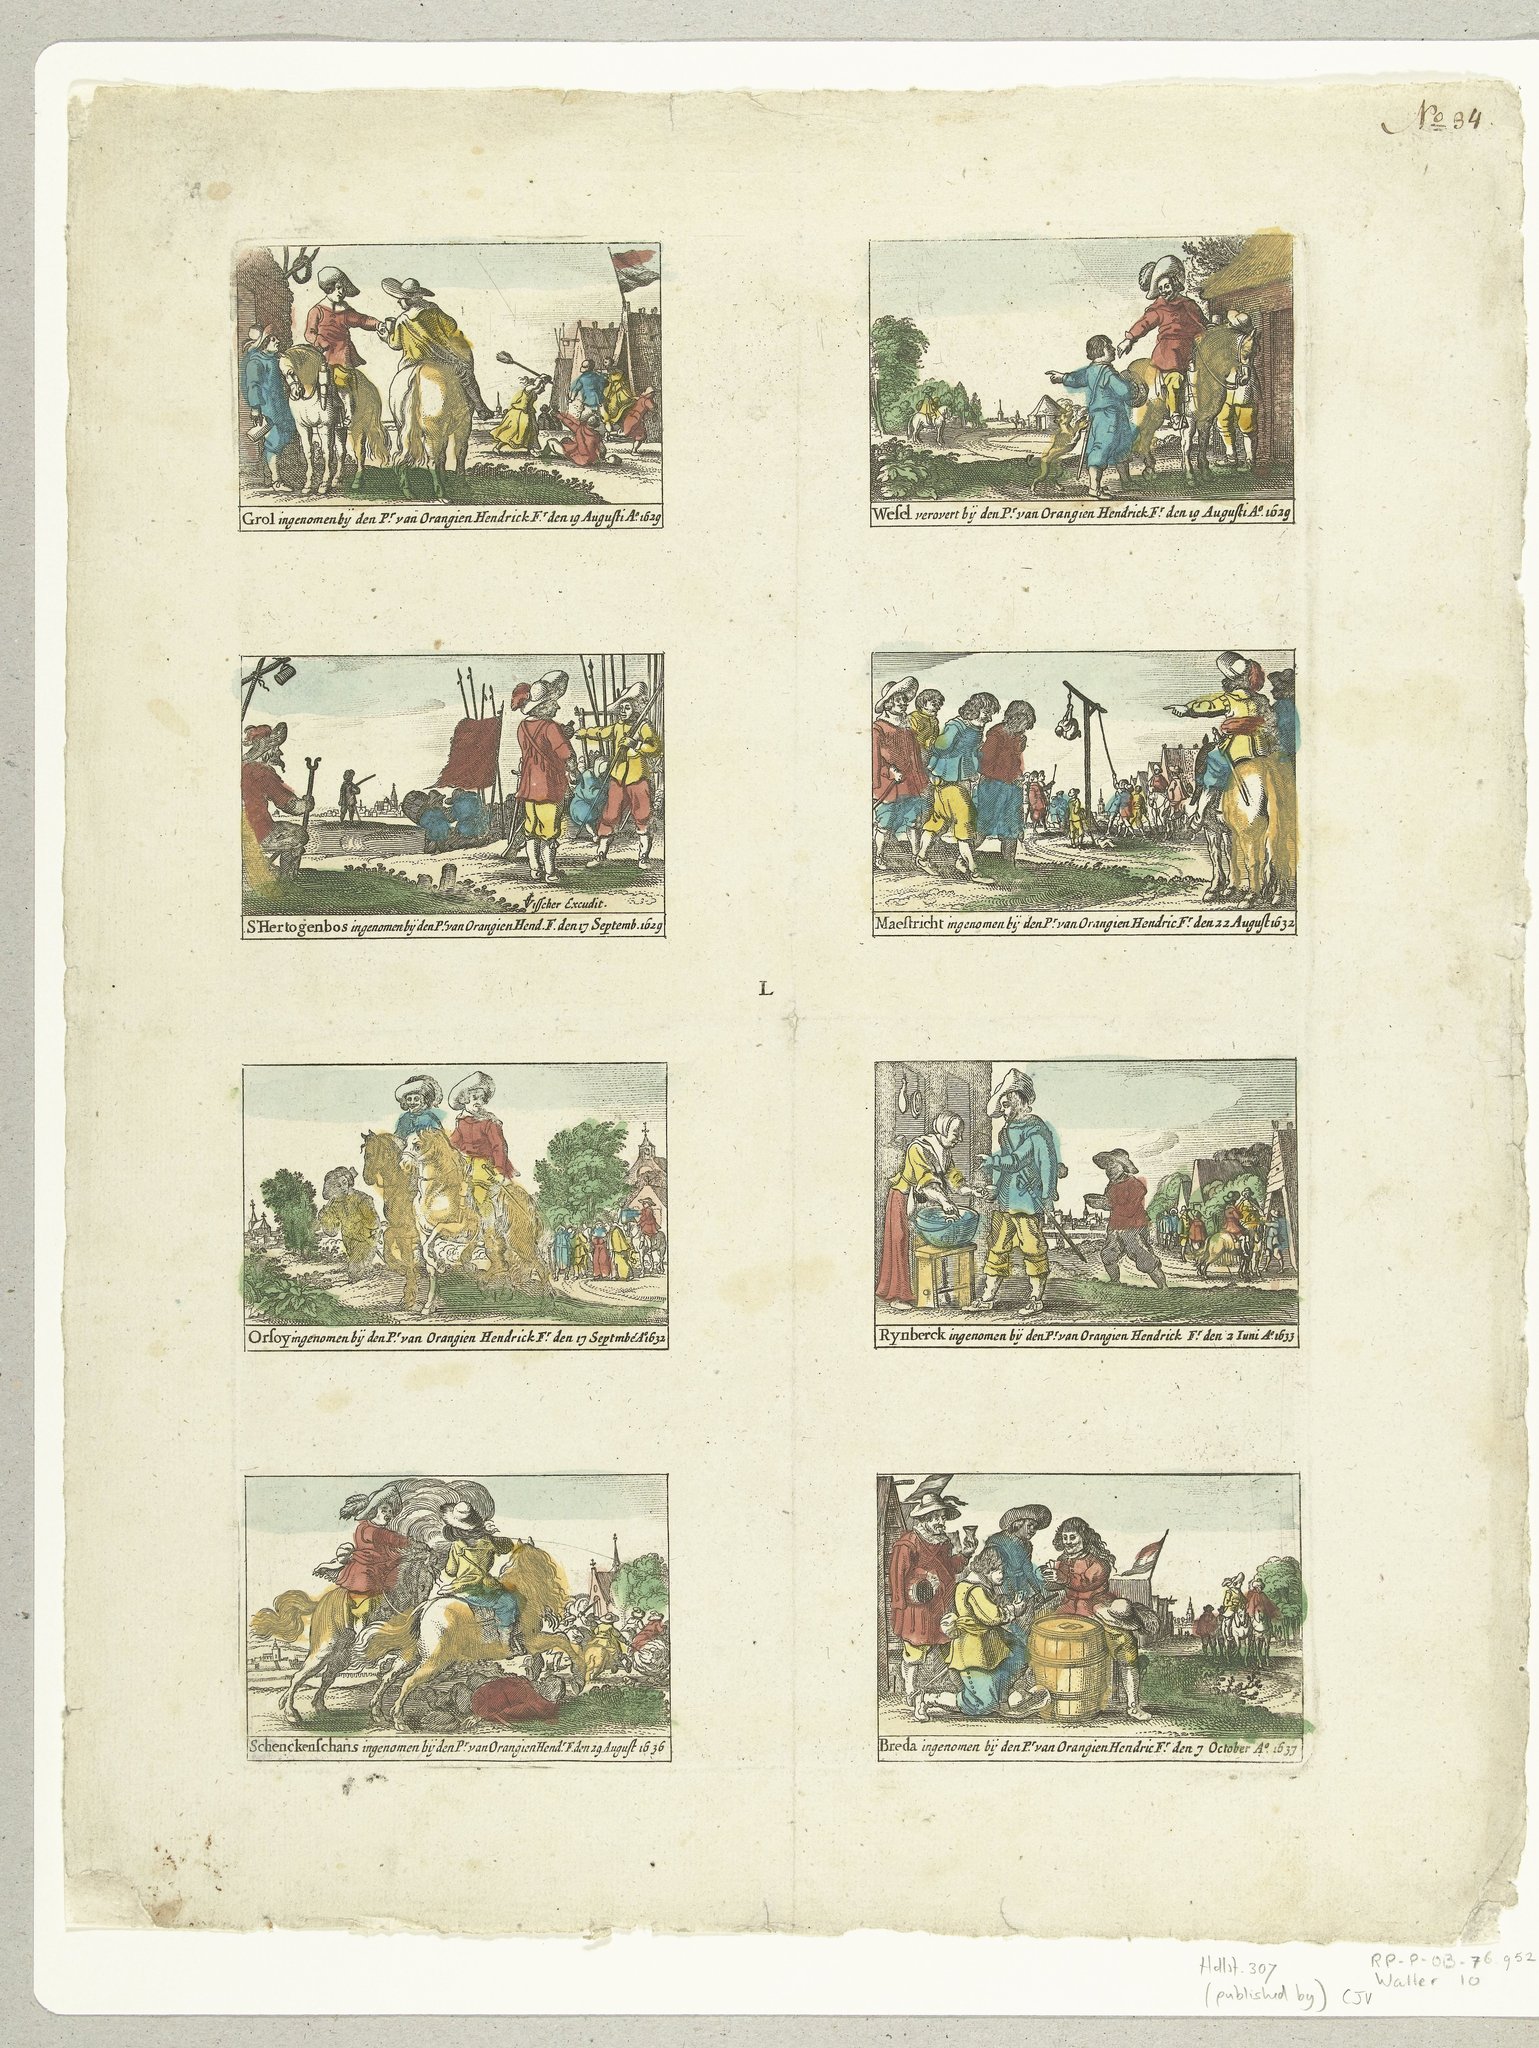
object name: print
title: Acht overwinningen van Frederik Hendrik, 1629-1637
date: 1637-1652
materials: paper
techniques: etching, hand coloring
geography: northern netherlands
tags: the hague, frederick henry (prince of orange), warfare; military affairs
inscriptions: collector's mark: Lugt 2760, inscription: ‘No 34’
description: Blad met 8 voorstellingen van overwinningen van Frederik Hendrik in de jaren 1629-1637, waaronder Grol (1629), Wesel (1629), Den Bosch (1629), Maastricht (1632), Orsoy (1632), Rijnberg (1633), Schenkenschans (1636) en Breda (1637). Acht aparte scènes gedrukt van één plaat. Onder elke afbeelding een regel onderschrift. Gemerkt in het midden: L.